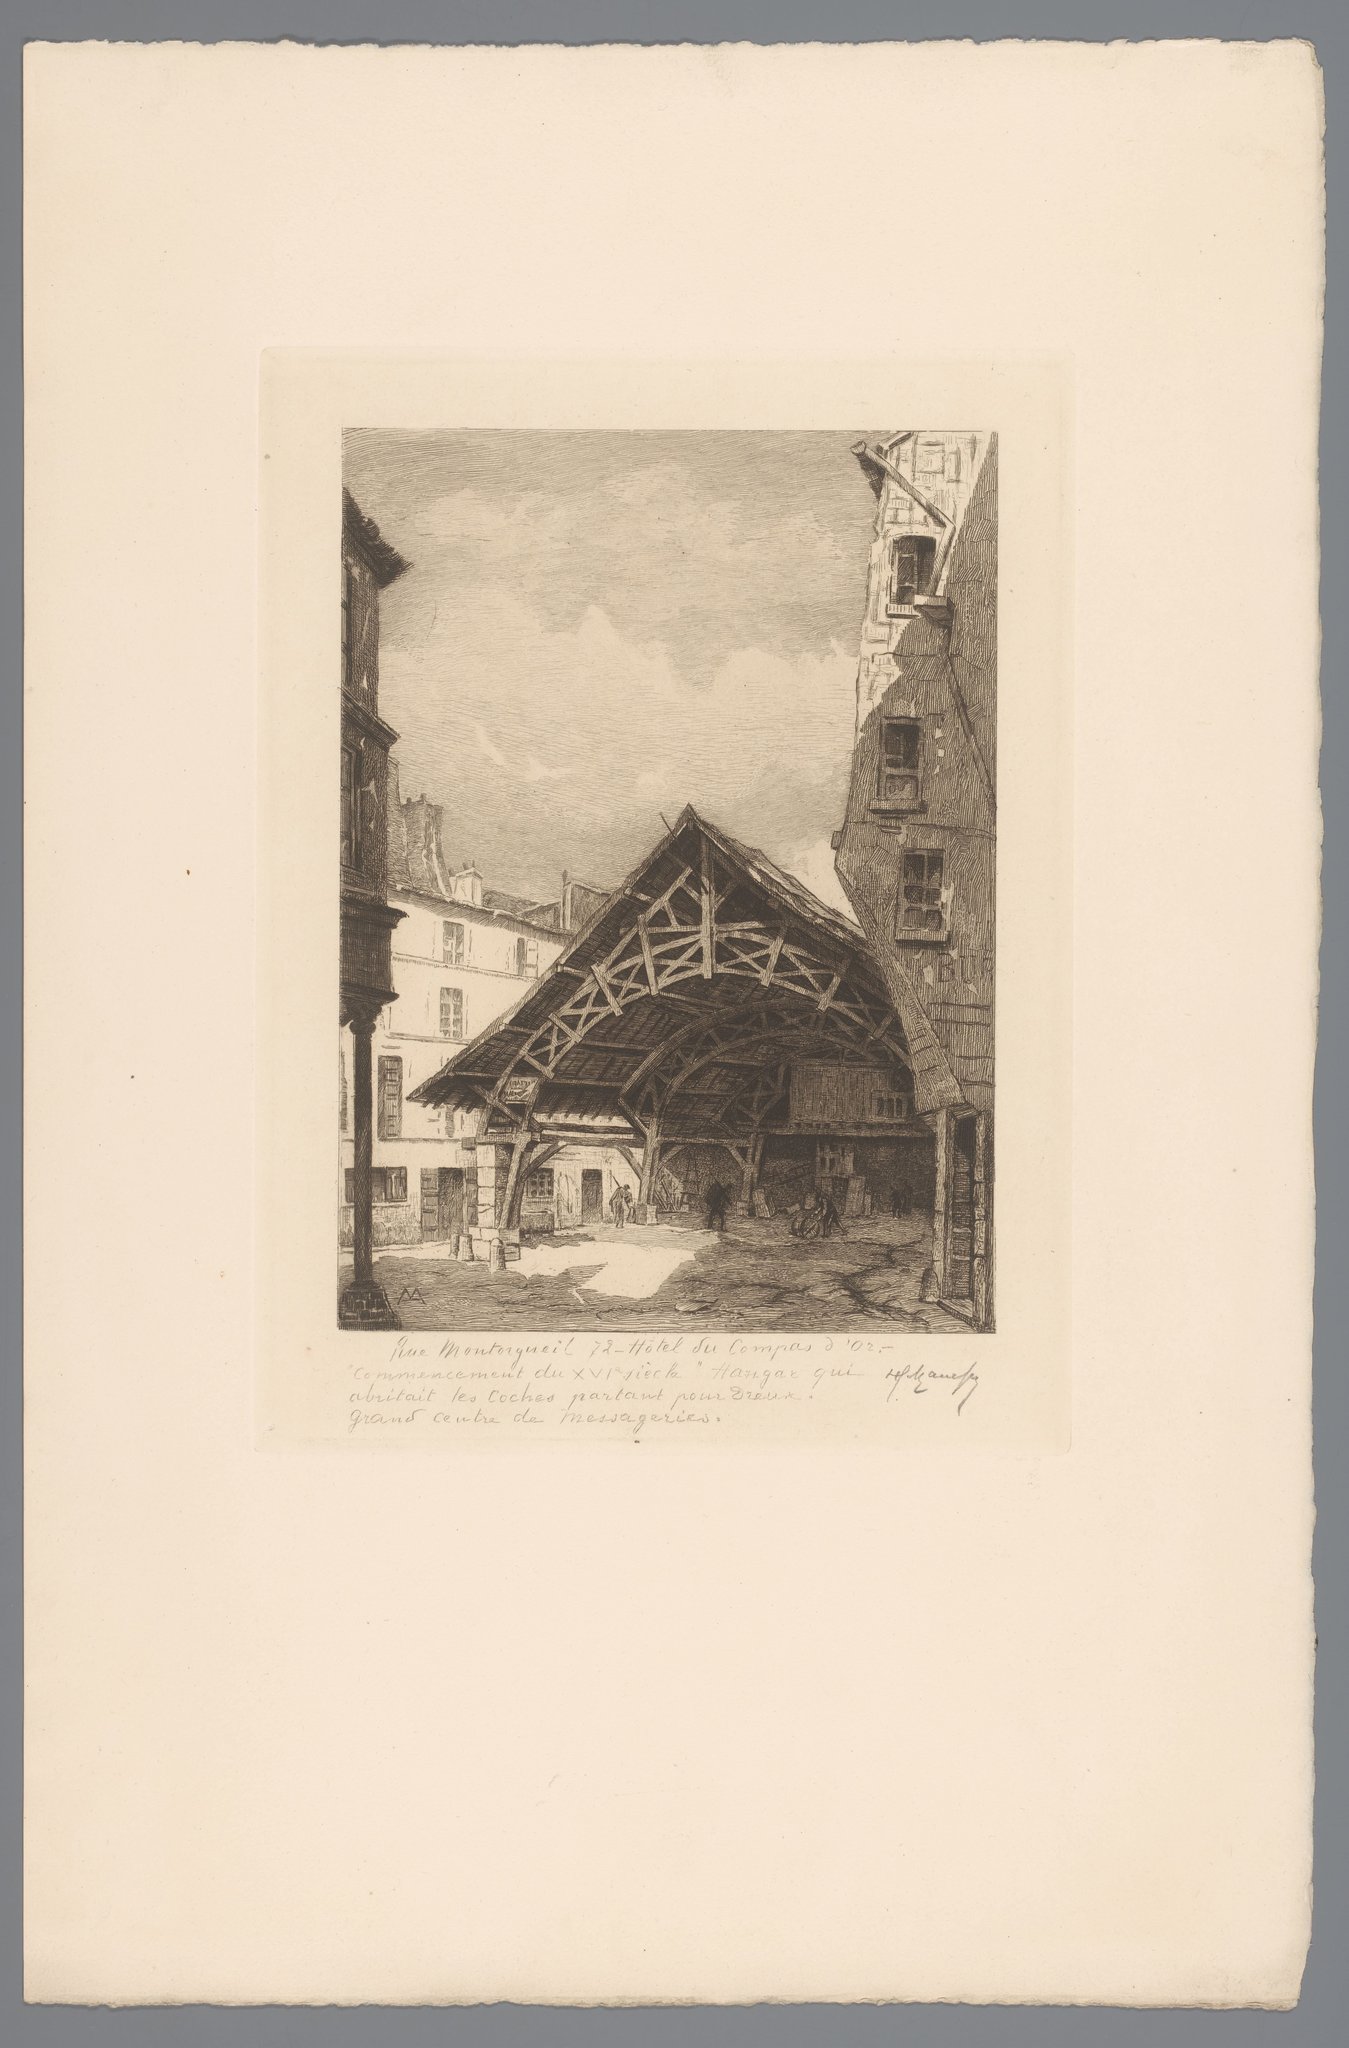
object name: print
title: Le vieux Paris s'en va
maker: henri manesse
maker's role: print maker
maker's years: 1854-1940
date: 1906-1911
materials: paper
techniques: drypoint, engraving, etching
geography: france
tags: city-view in general; 'veduta'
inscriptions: collector's mark: Lugt 2228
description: Dit is de eerste serie uit een prentreeks die uit minstens elf series bestaat.